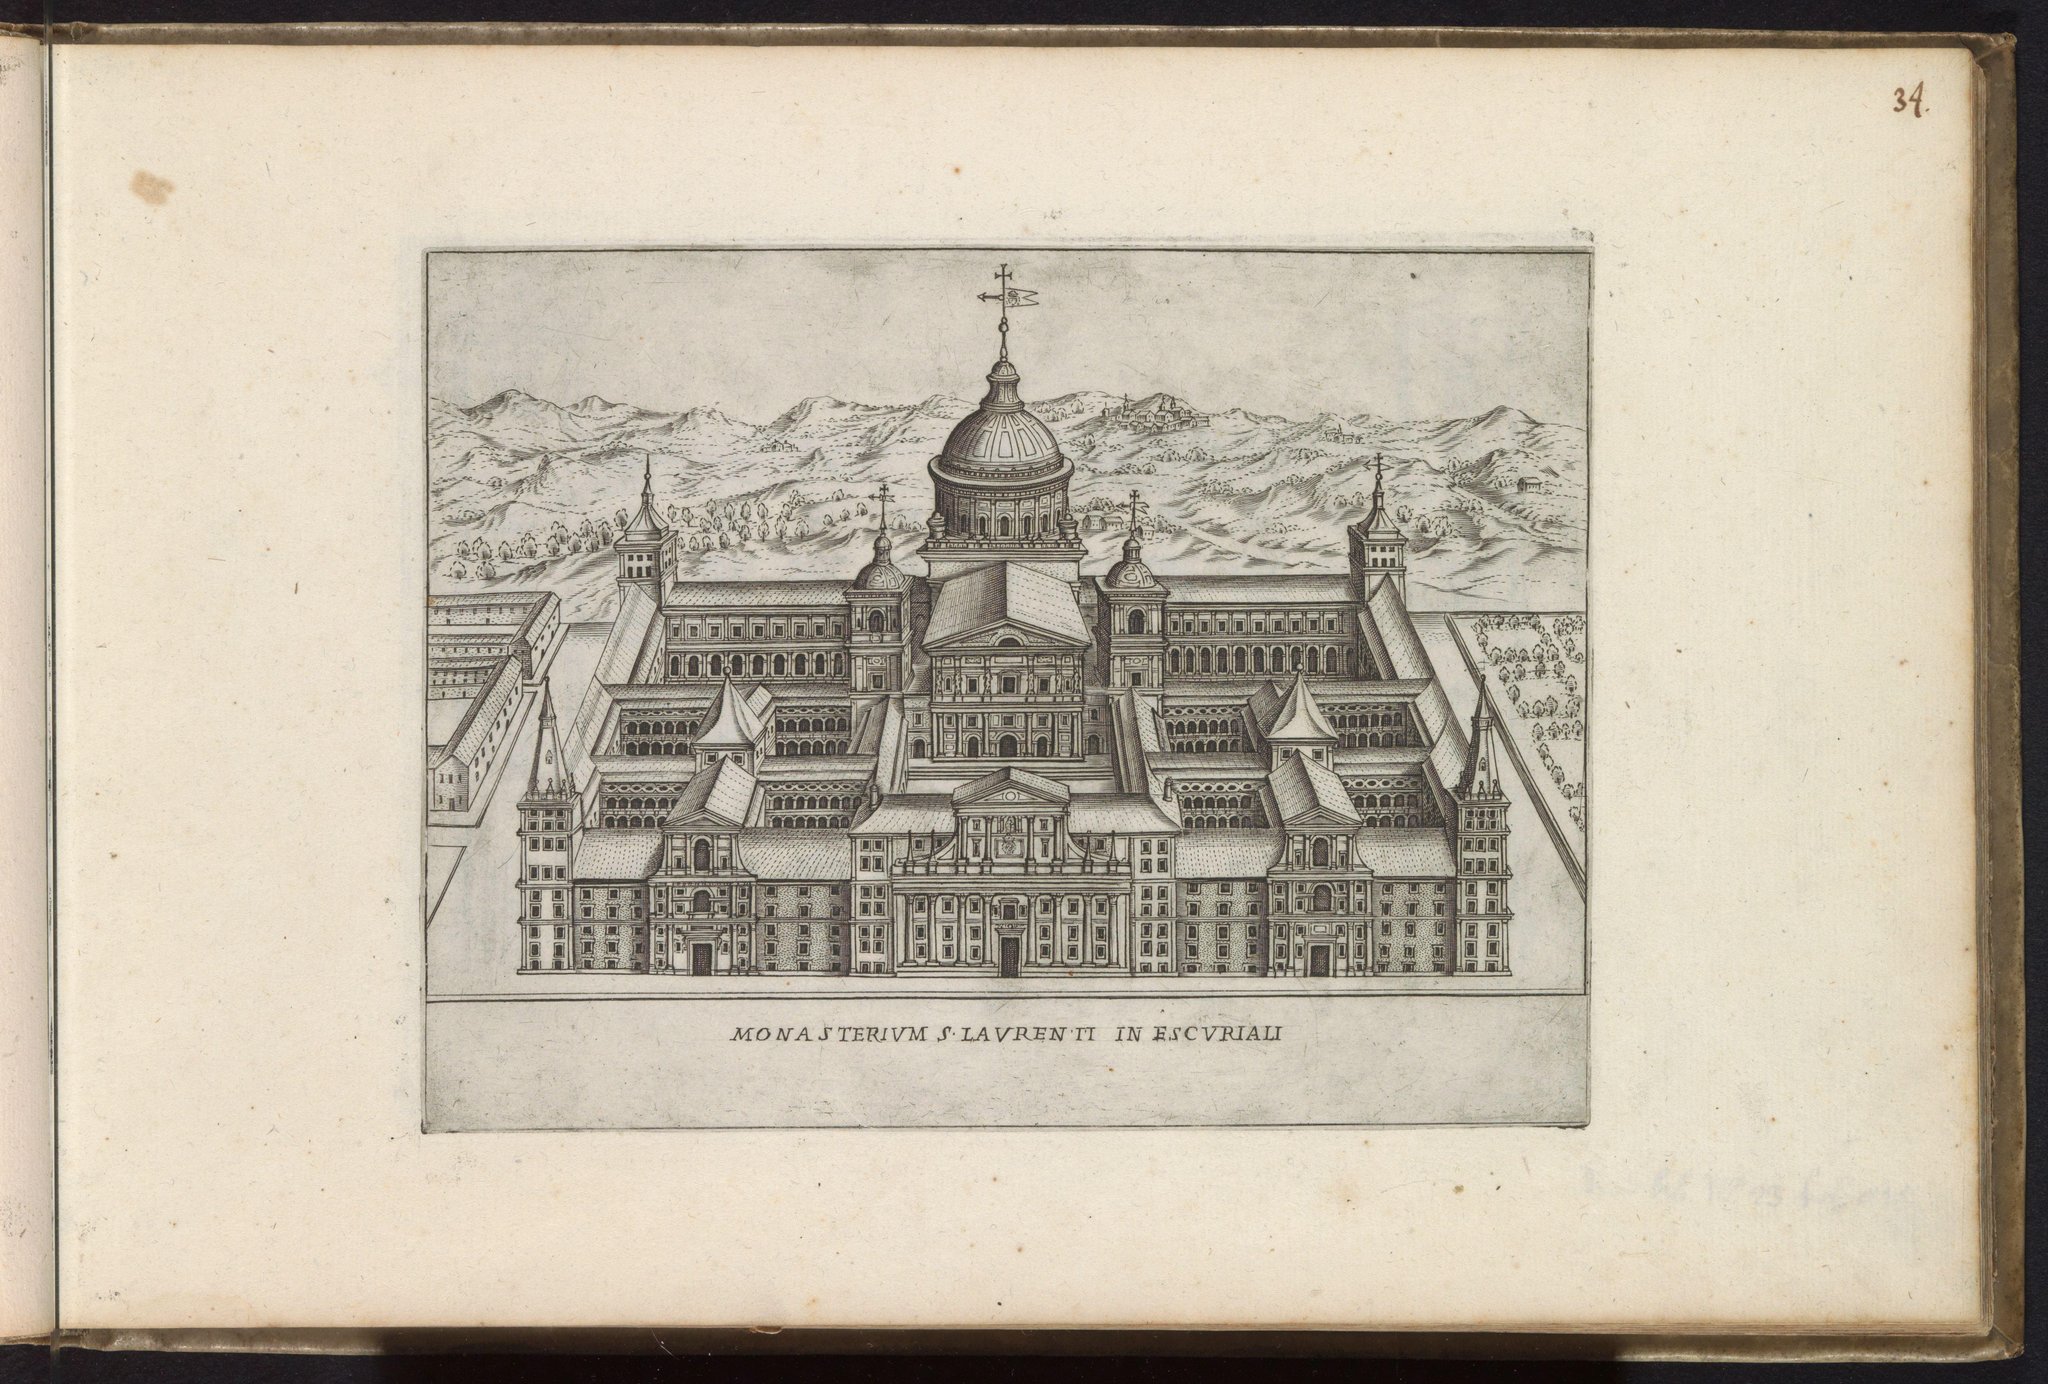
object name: print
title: Palazzi diversi nel'alma cità di Roma, et altre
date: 1638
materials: paper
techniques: etching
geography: vatican city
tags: castle, abbey, monastery, convent ~ roman catholic church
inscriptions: number: ‘34’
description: Gezicht op het abdijcomplex het Escorial te San Lorenzo de El Escorial in Spanje. Prent maakt deel uit van een album.